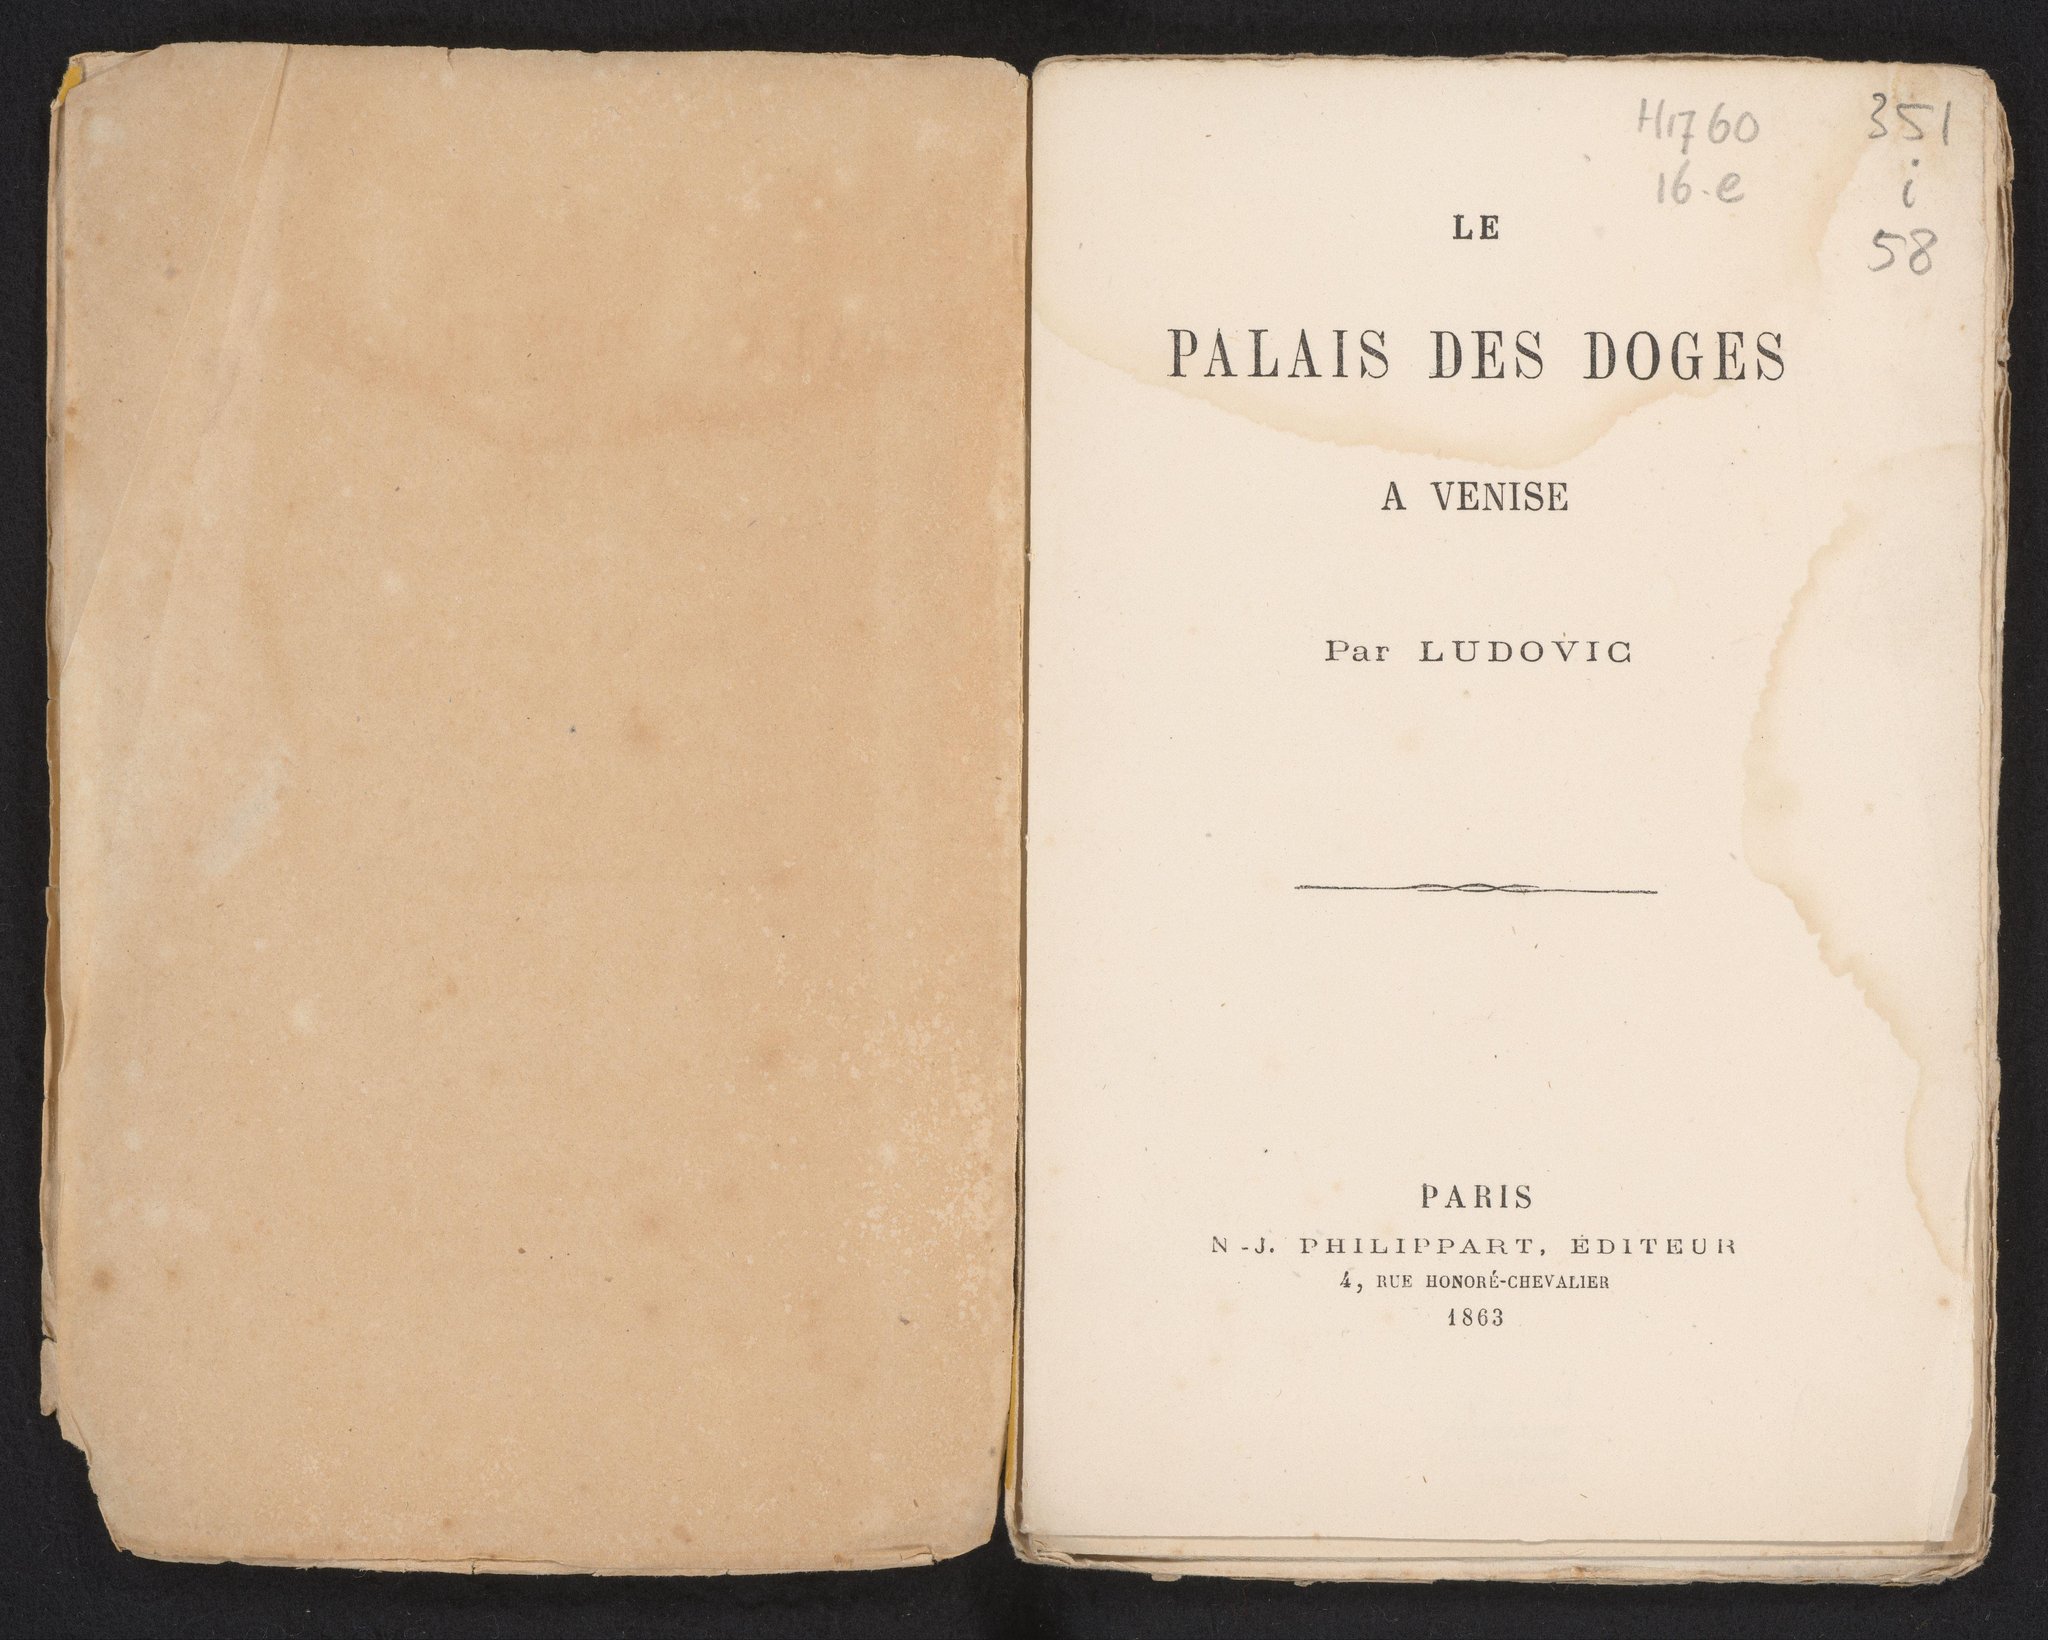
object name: book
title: Le Palais des Doges à Venise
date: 1863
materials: paper, cardboard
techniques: albumen print, letterpress printing, lithograph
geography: paris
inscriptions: inscription: ‘H88/1319/76/ 4 plaq.’